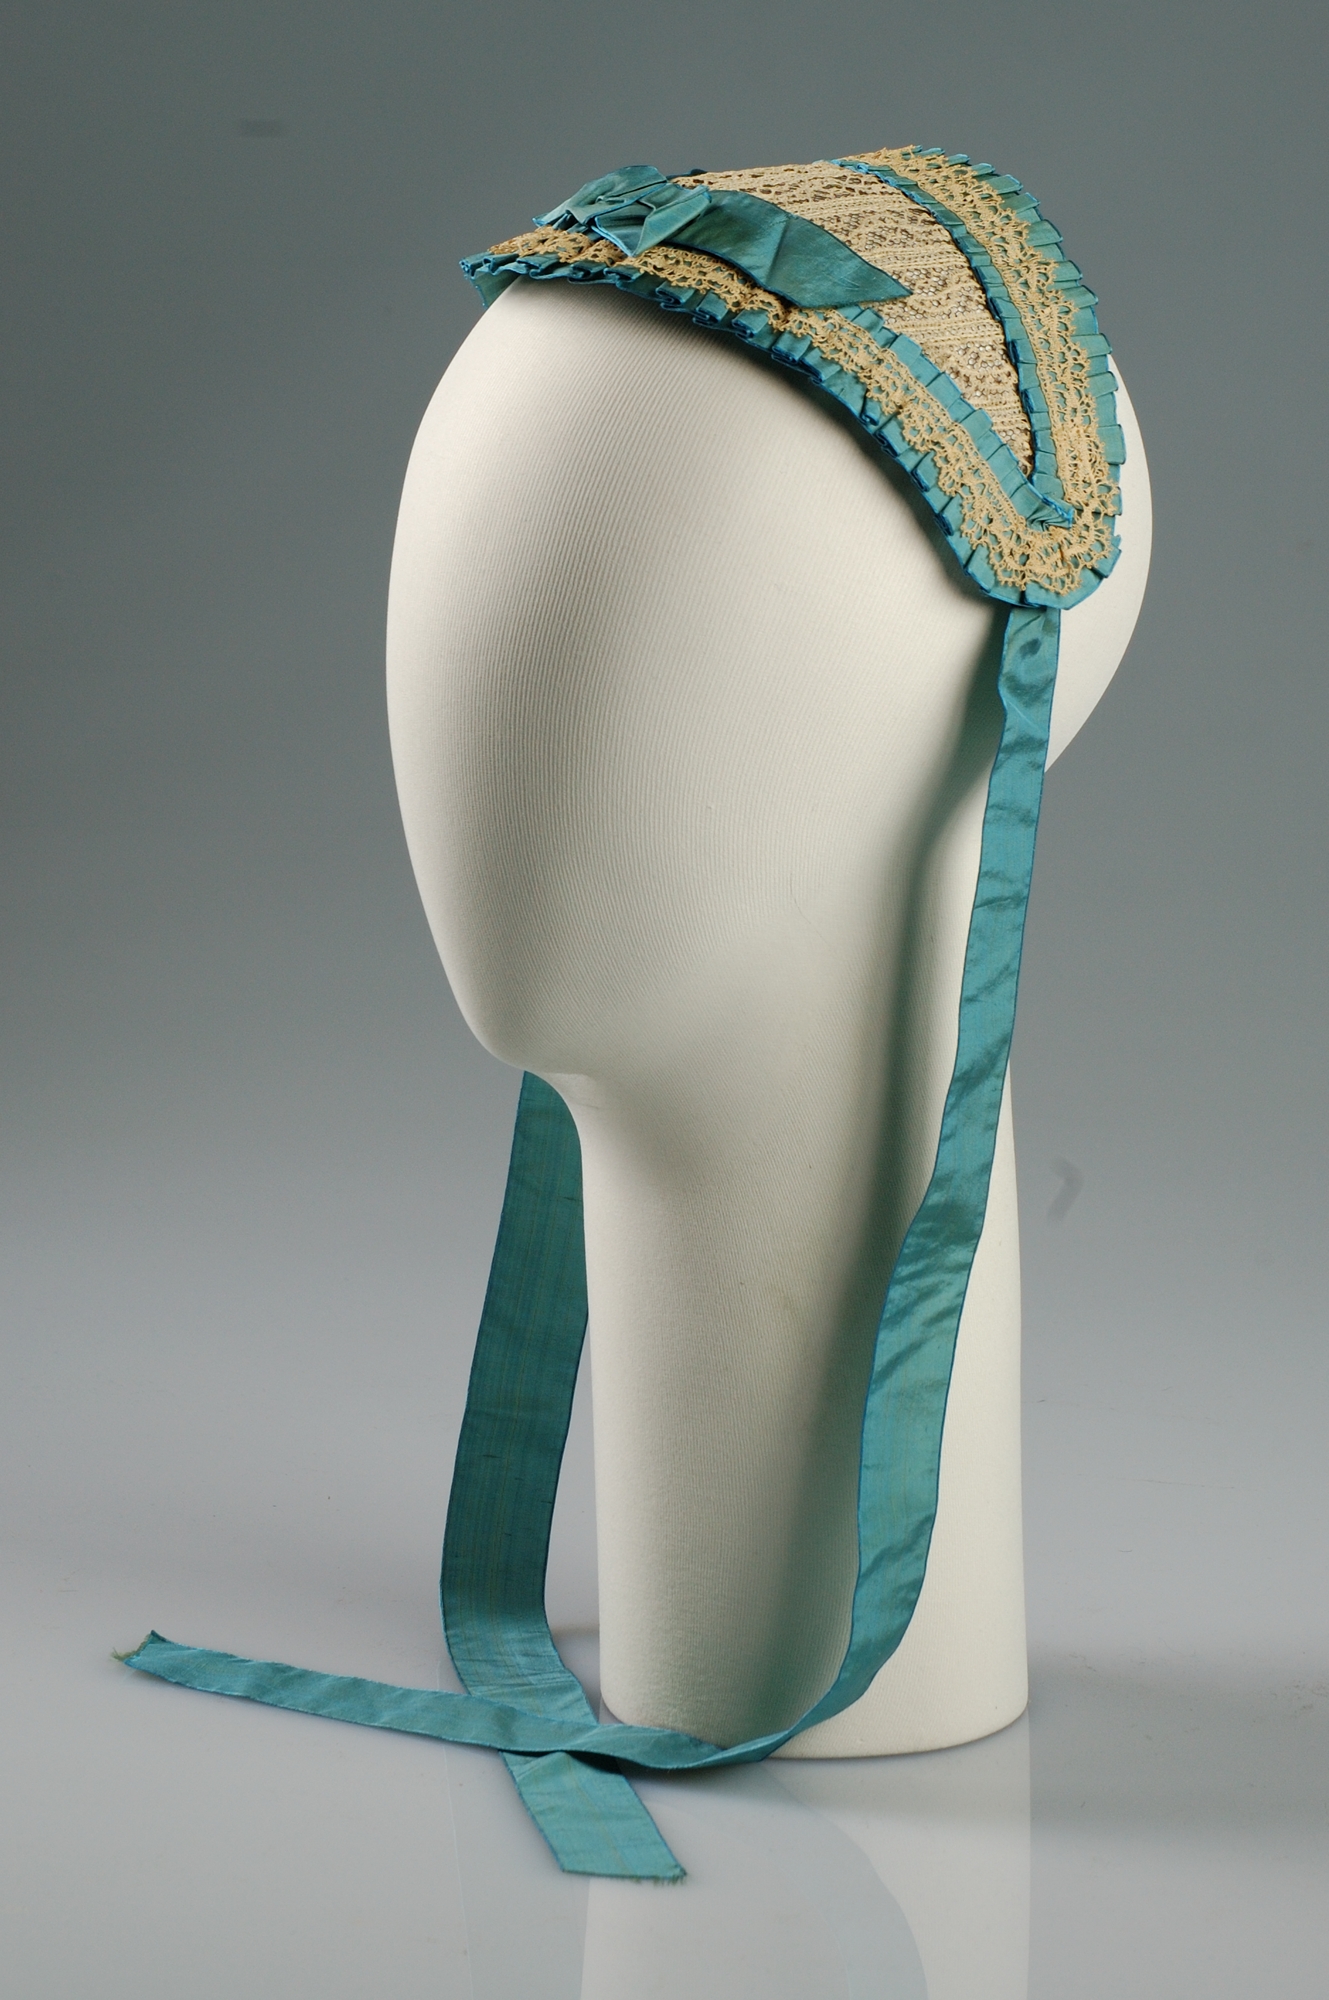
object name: cap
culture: american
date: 1870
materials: linen, silk